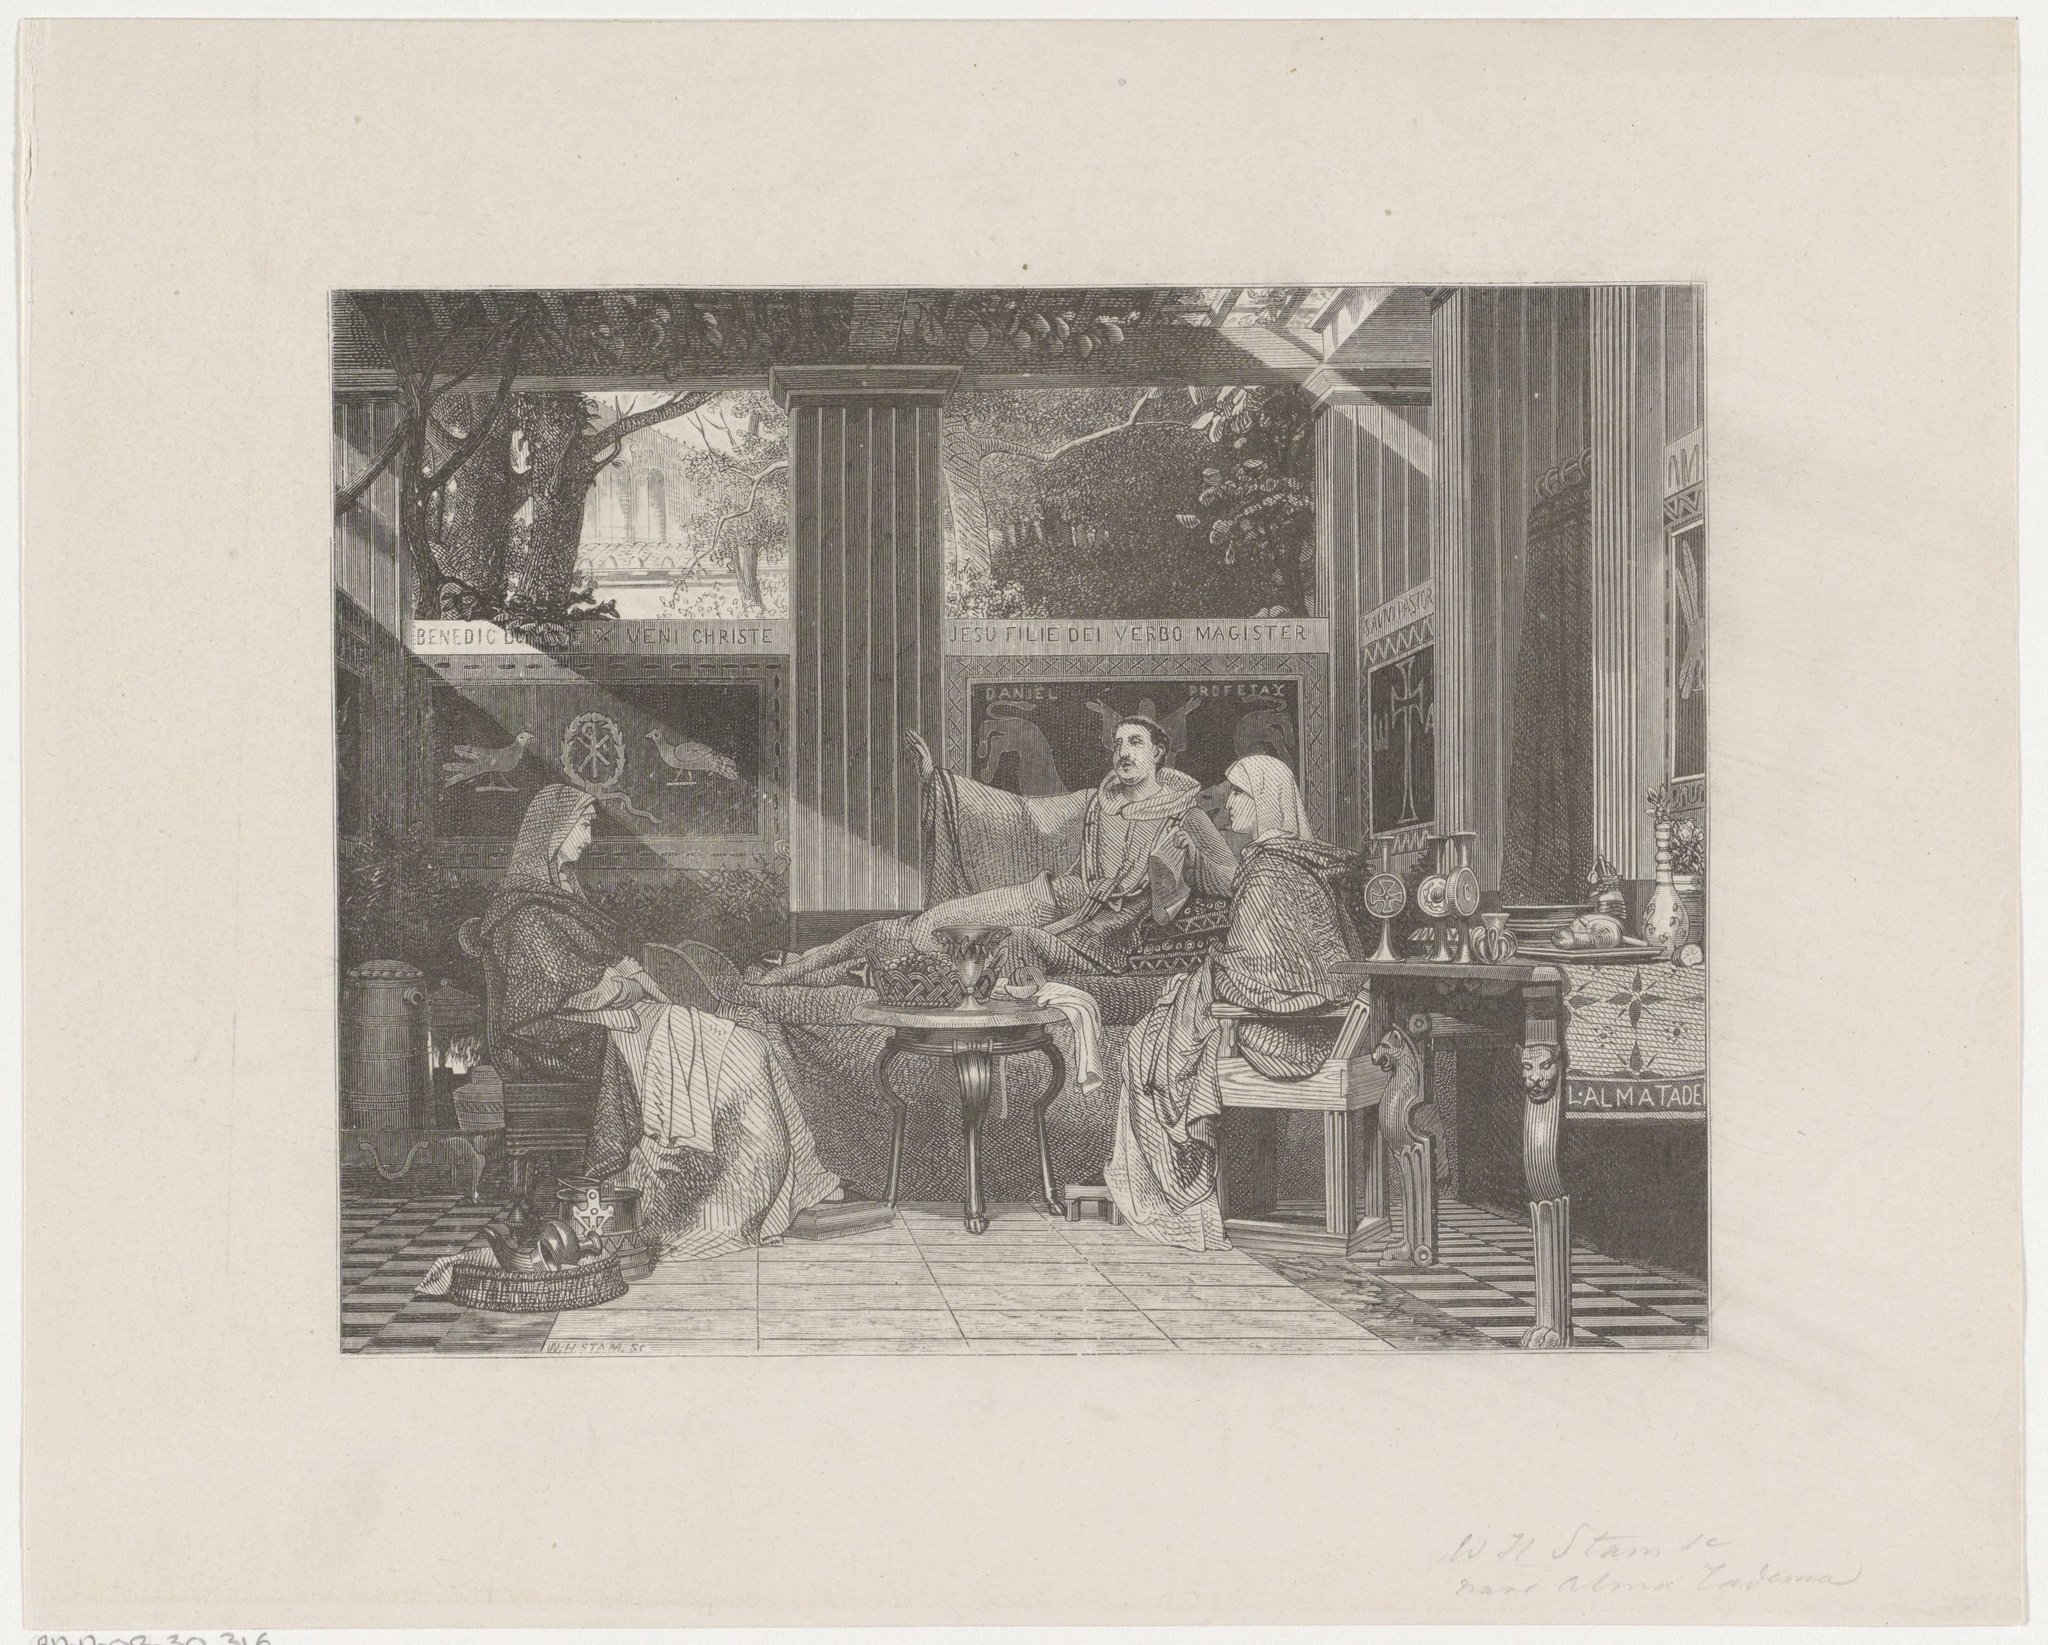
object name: print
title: Classicistische scène met een man op een sofa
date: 1841-1874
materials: paper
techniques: engraving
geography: the hague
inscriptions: collector's mark: Lugt 2228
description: Een man ligt op een sofa met naast hem een kelk en een tros druiven in een schaal. Twee vrouwen zitten in een stoel tegenover hem.